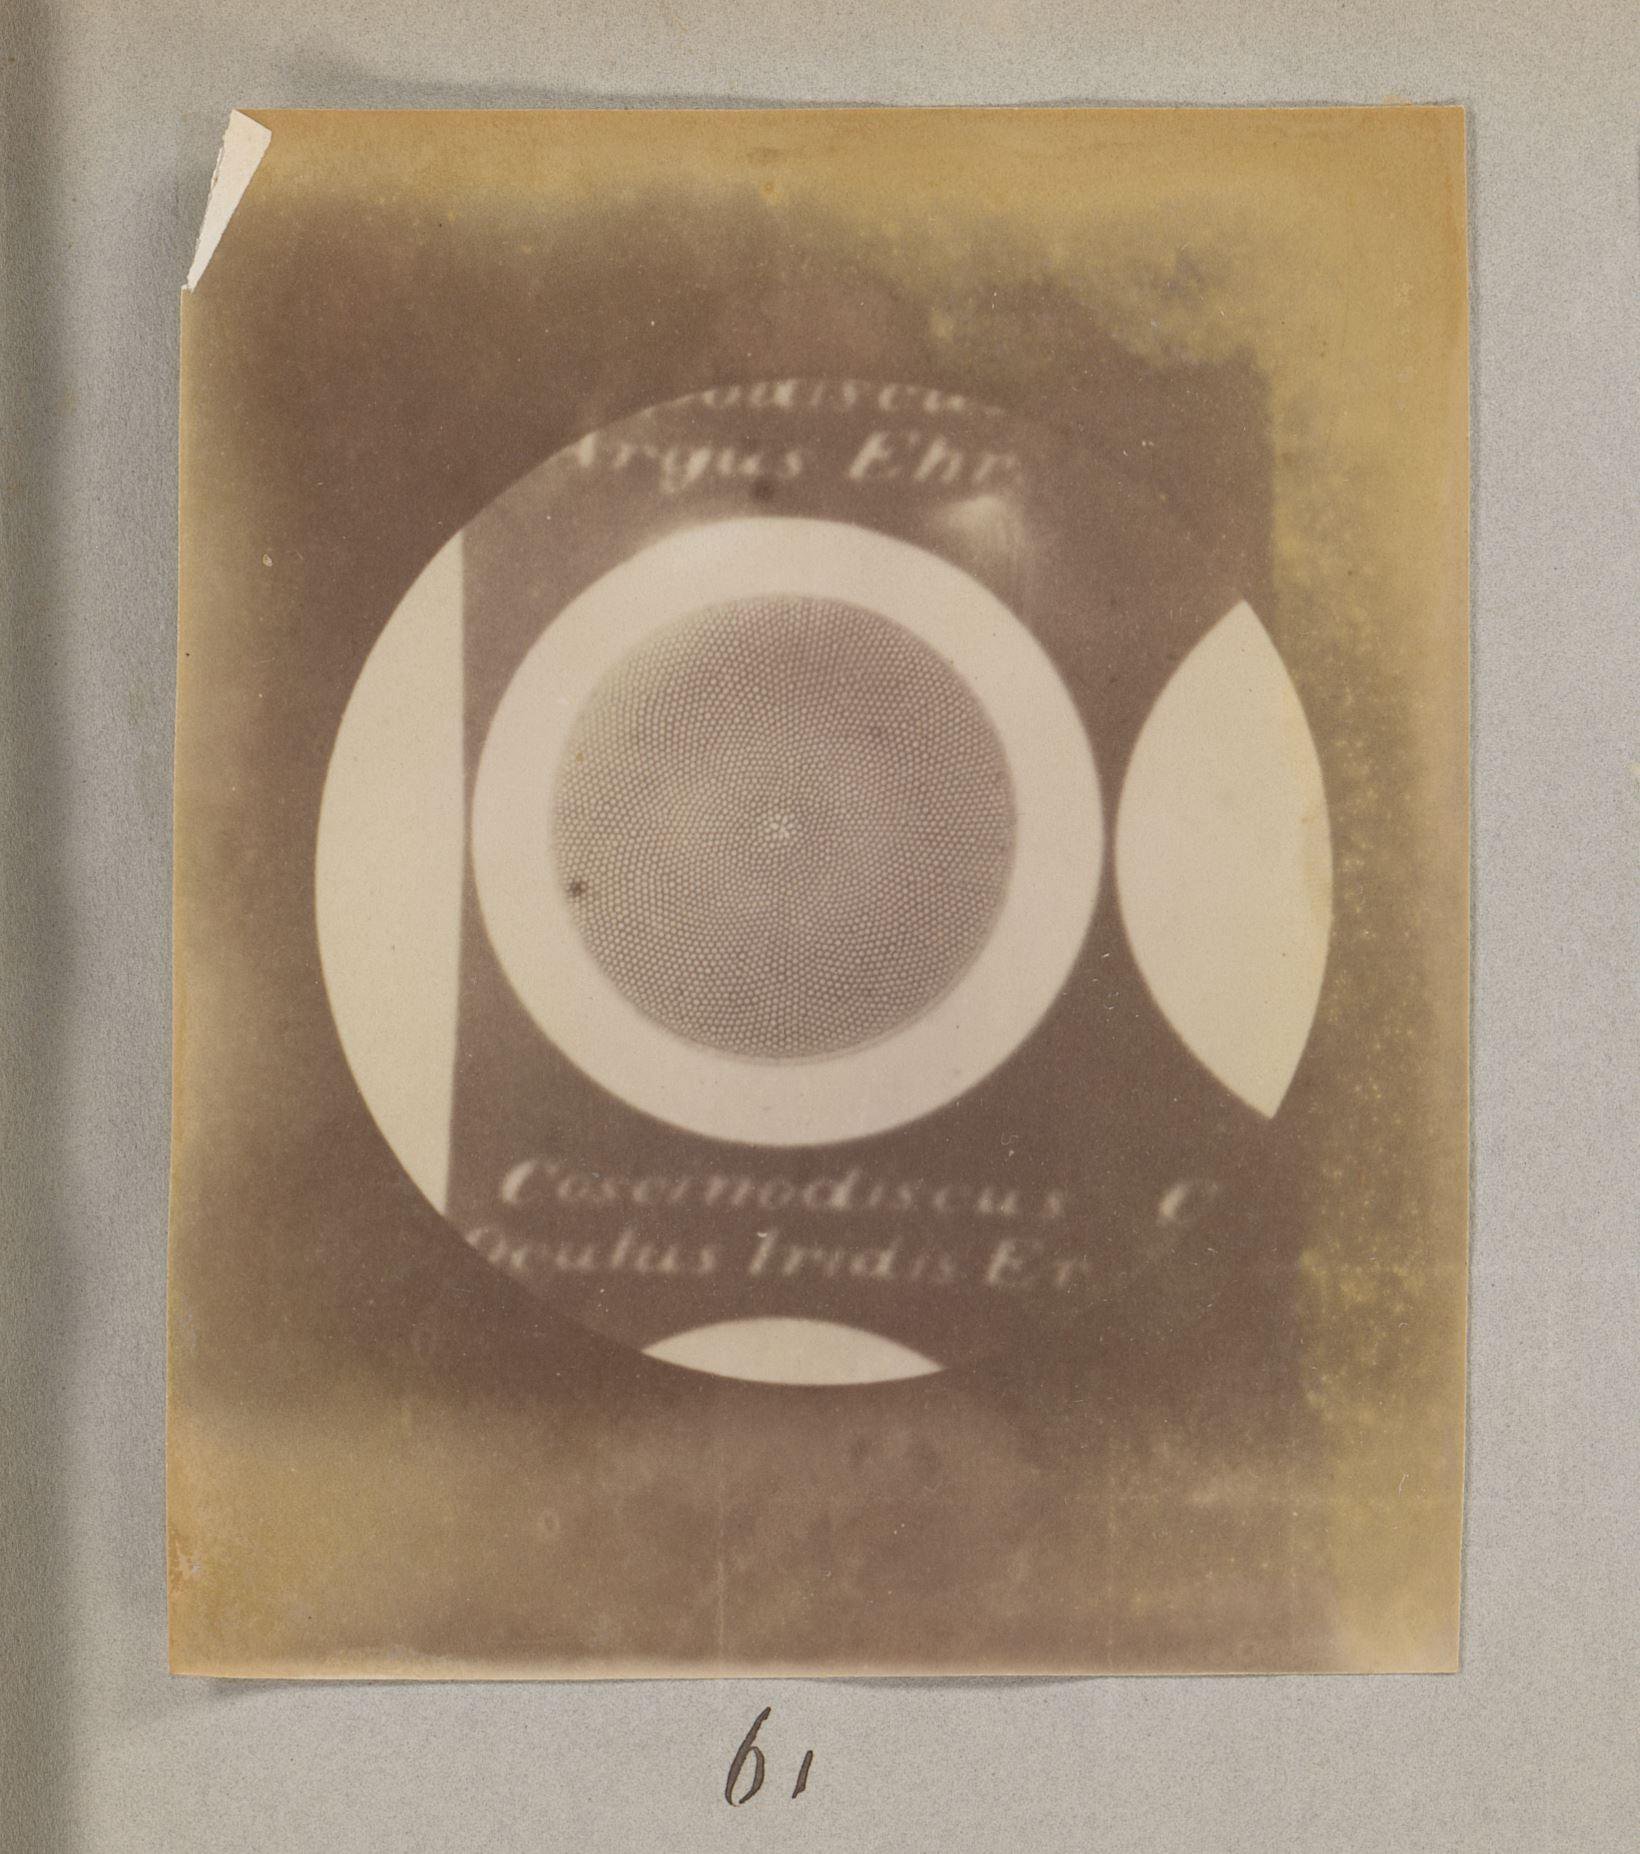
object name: album leaf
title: Microscopische opname van coscinodiscus-diatomeeën, 190 keer vergroot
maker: marinus pieter filbri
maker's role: instrument maker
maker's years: 1852-1917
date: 1887-1888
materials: paper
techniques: albumen print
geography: netherlands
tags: algae, seaweed, netherlands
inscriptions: inscription: ‘No. 61. Benaming Cosenodiscus Diatomeen, vergroting 190x, pose 10 min, bemerking Clarcke’, number: ‘61’